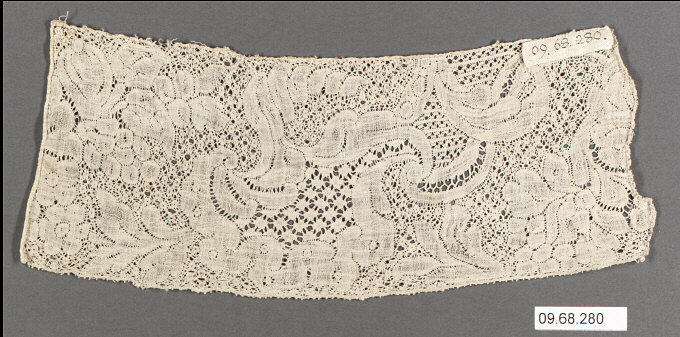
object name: fragment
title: Fragment of lace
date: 1701-1800